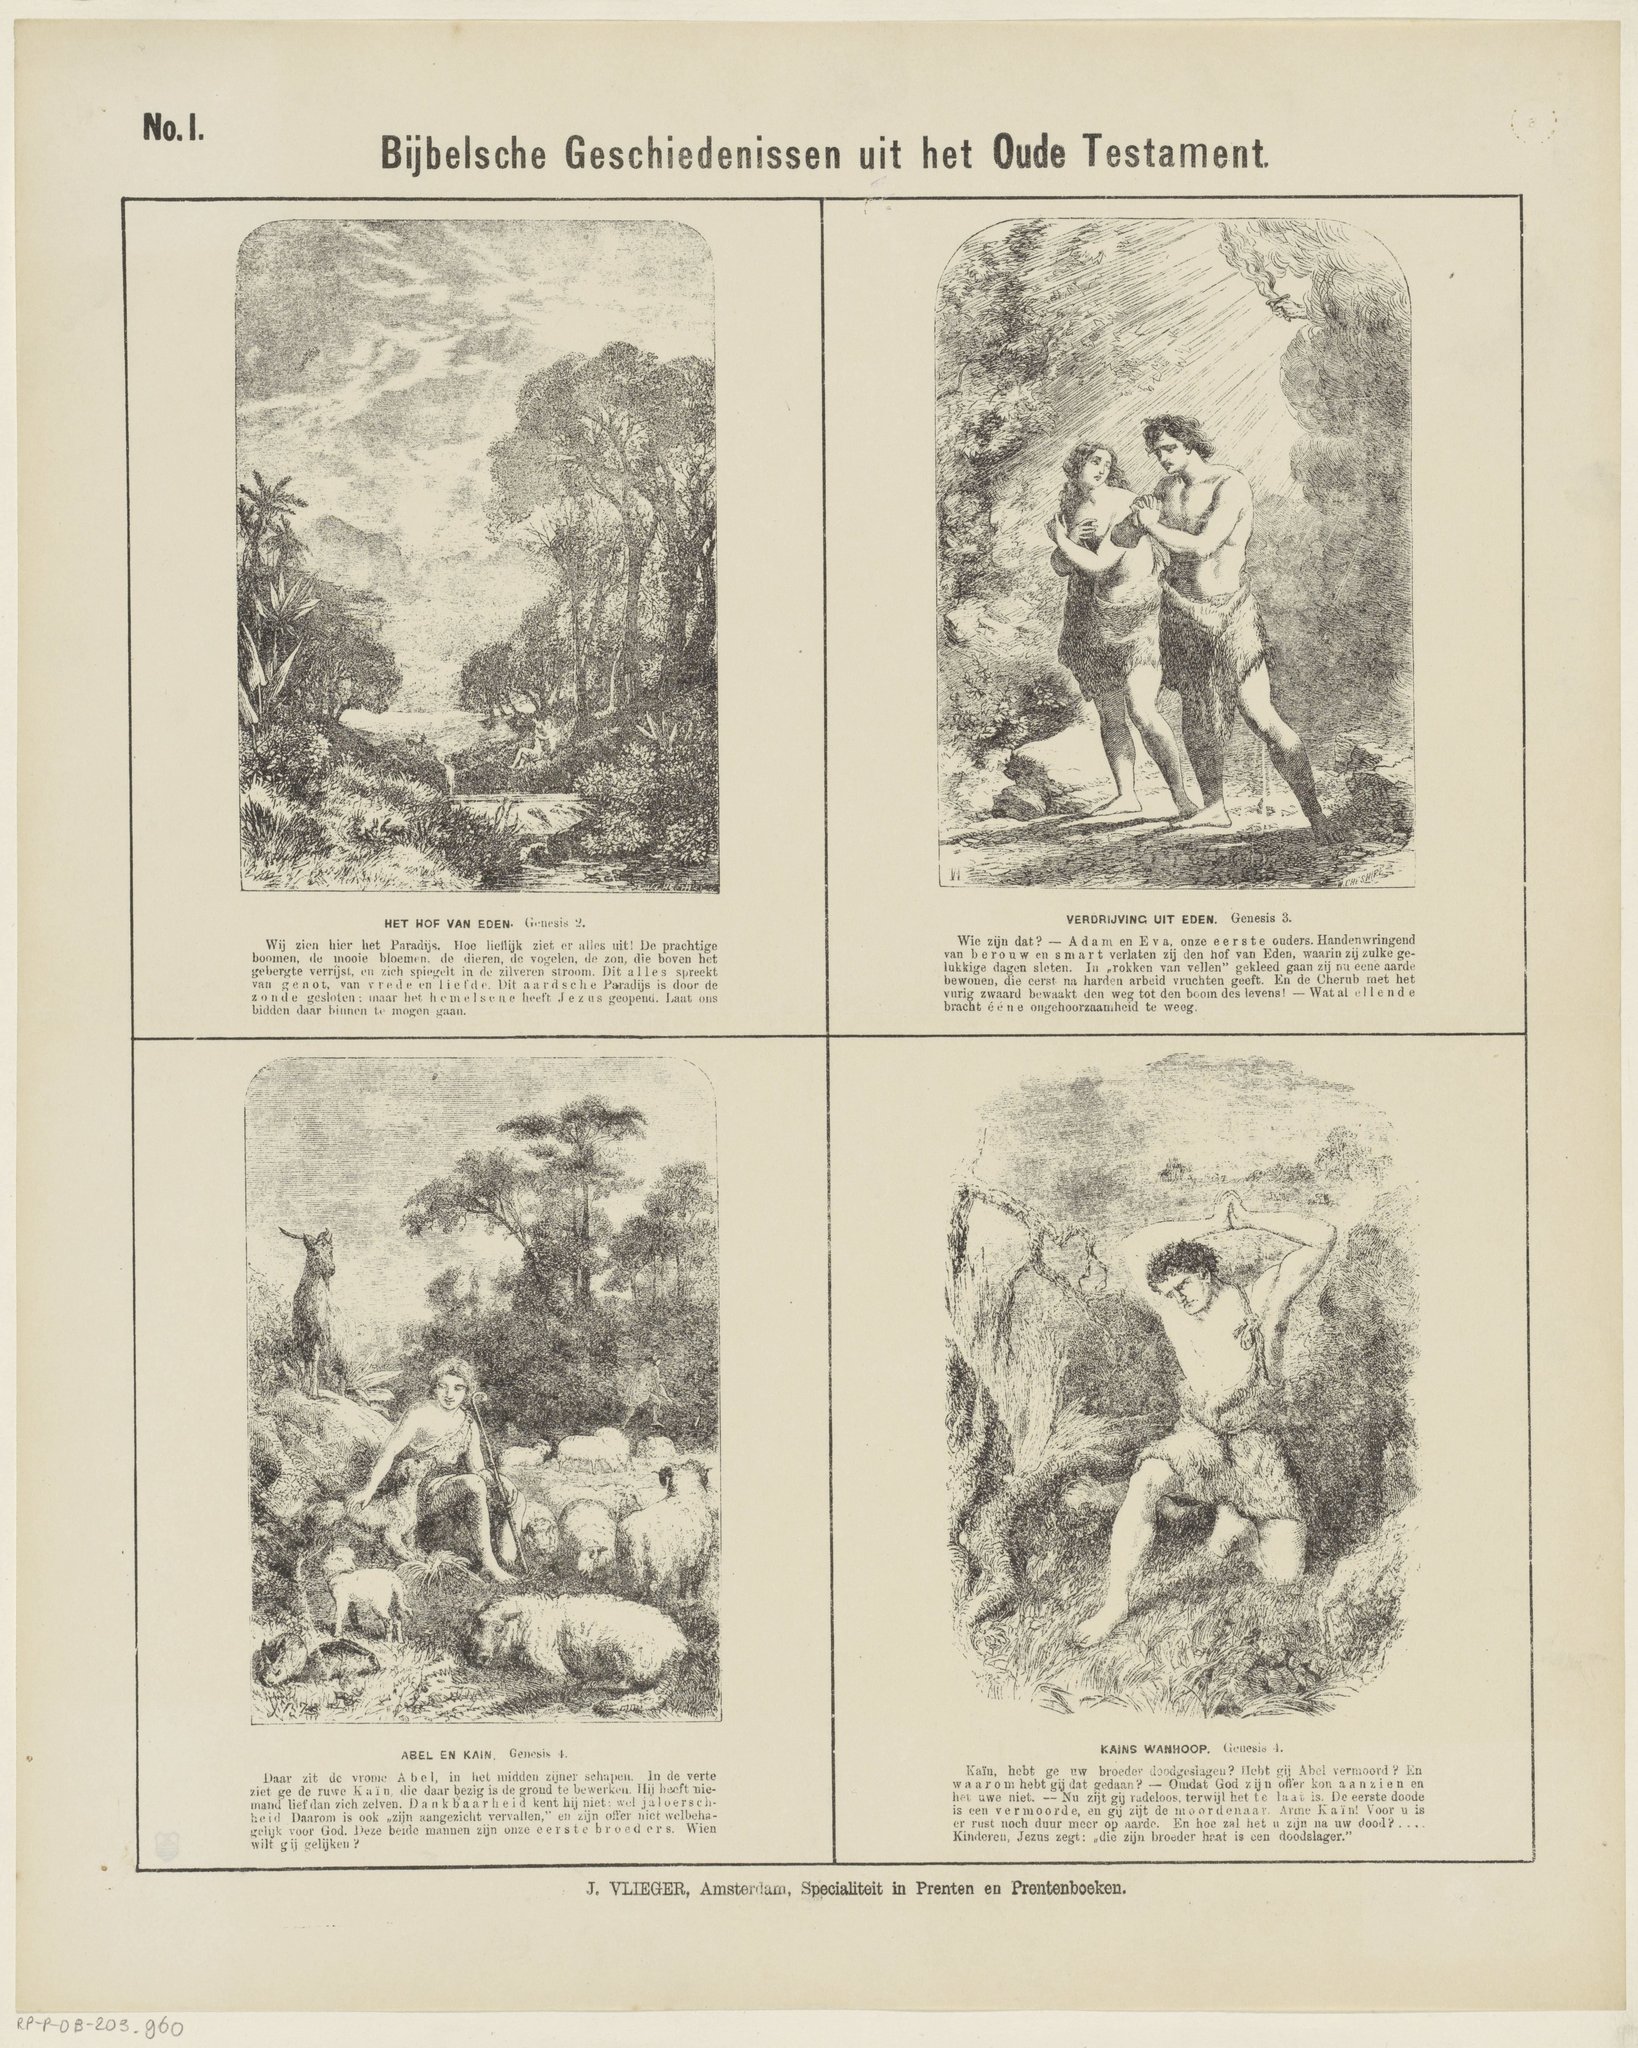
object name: print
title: Bijbelsche geschiedenissen uit het Oude Testament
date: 1871-1908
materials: paper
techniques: letterpress printing, engraving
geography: amsterdam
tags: cain repentant, expulsion of adam and eve from paradise (genesis 3:22-24), garden of eden, paradise, old testament, the story of cain and abel (genesis 4:3-17)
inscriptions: collector's mark: Lugt 2760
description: Blad met 4 voorstellingen van verhalen uit het Oude Testament. Het hof van Eden, de verdrijving van Adam en Eva uit het paradijs, Kaïn en Abel met schapen in een weiland en Kaïn die berouw toont na de moord op Abel. Onder elke afbeelding de bijbehorende Bijbeltekst. Genummerd linksboven: No. 5.